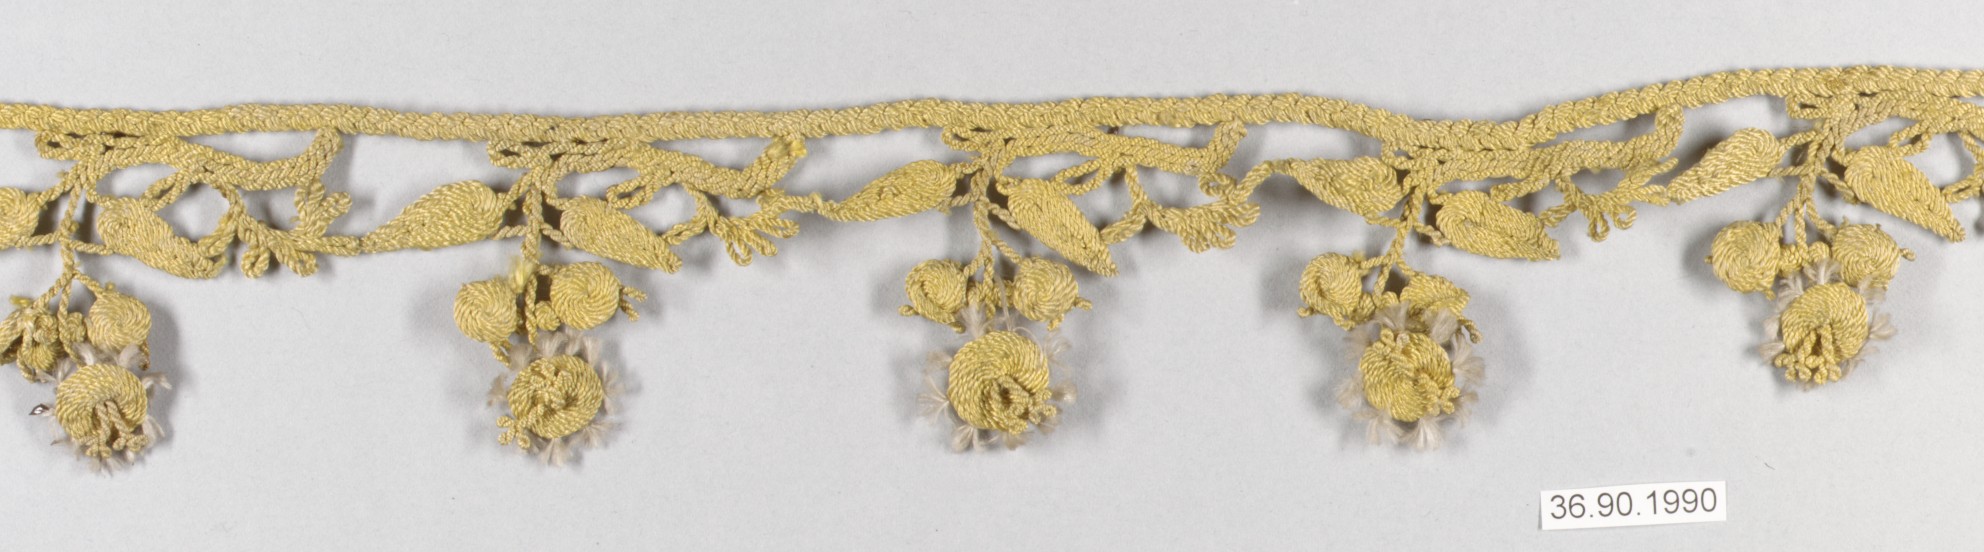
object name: fringe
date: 1701-1733